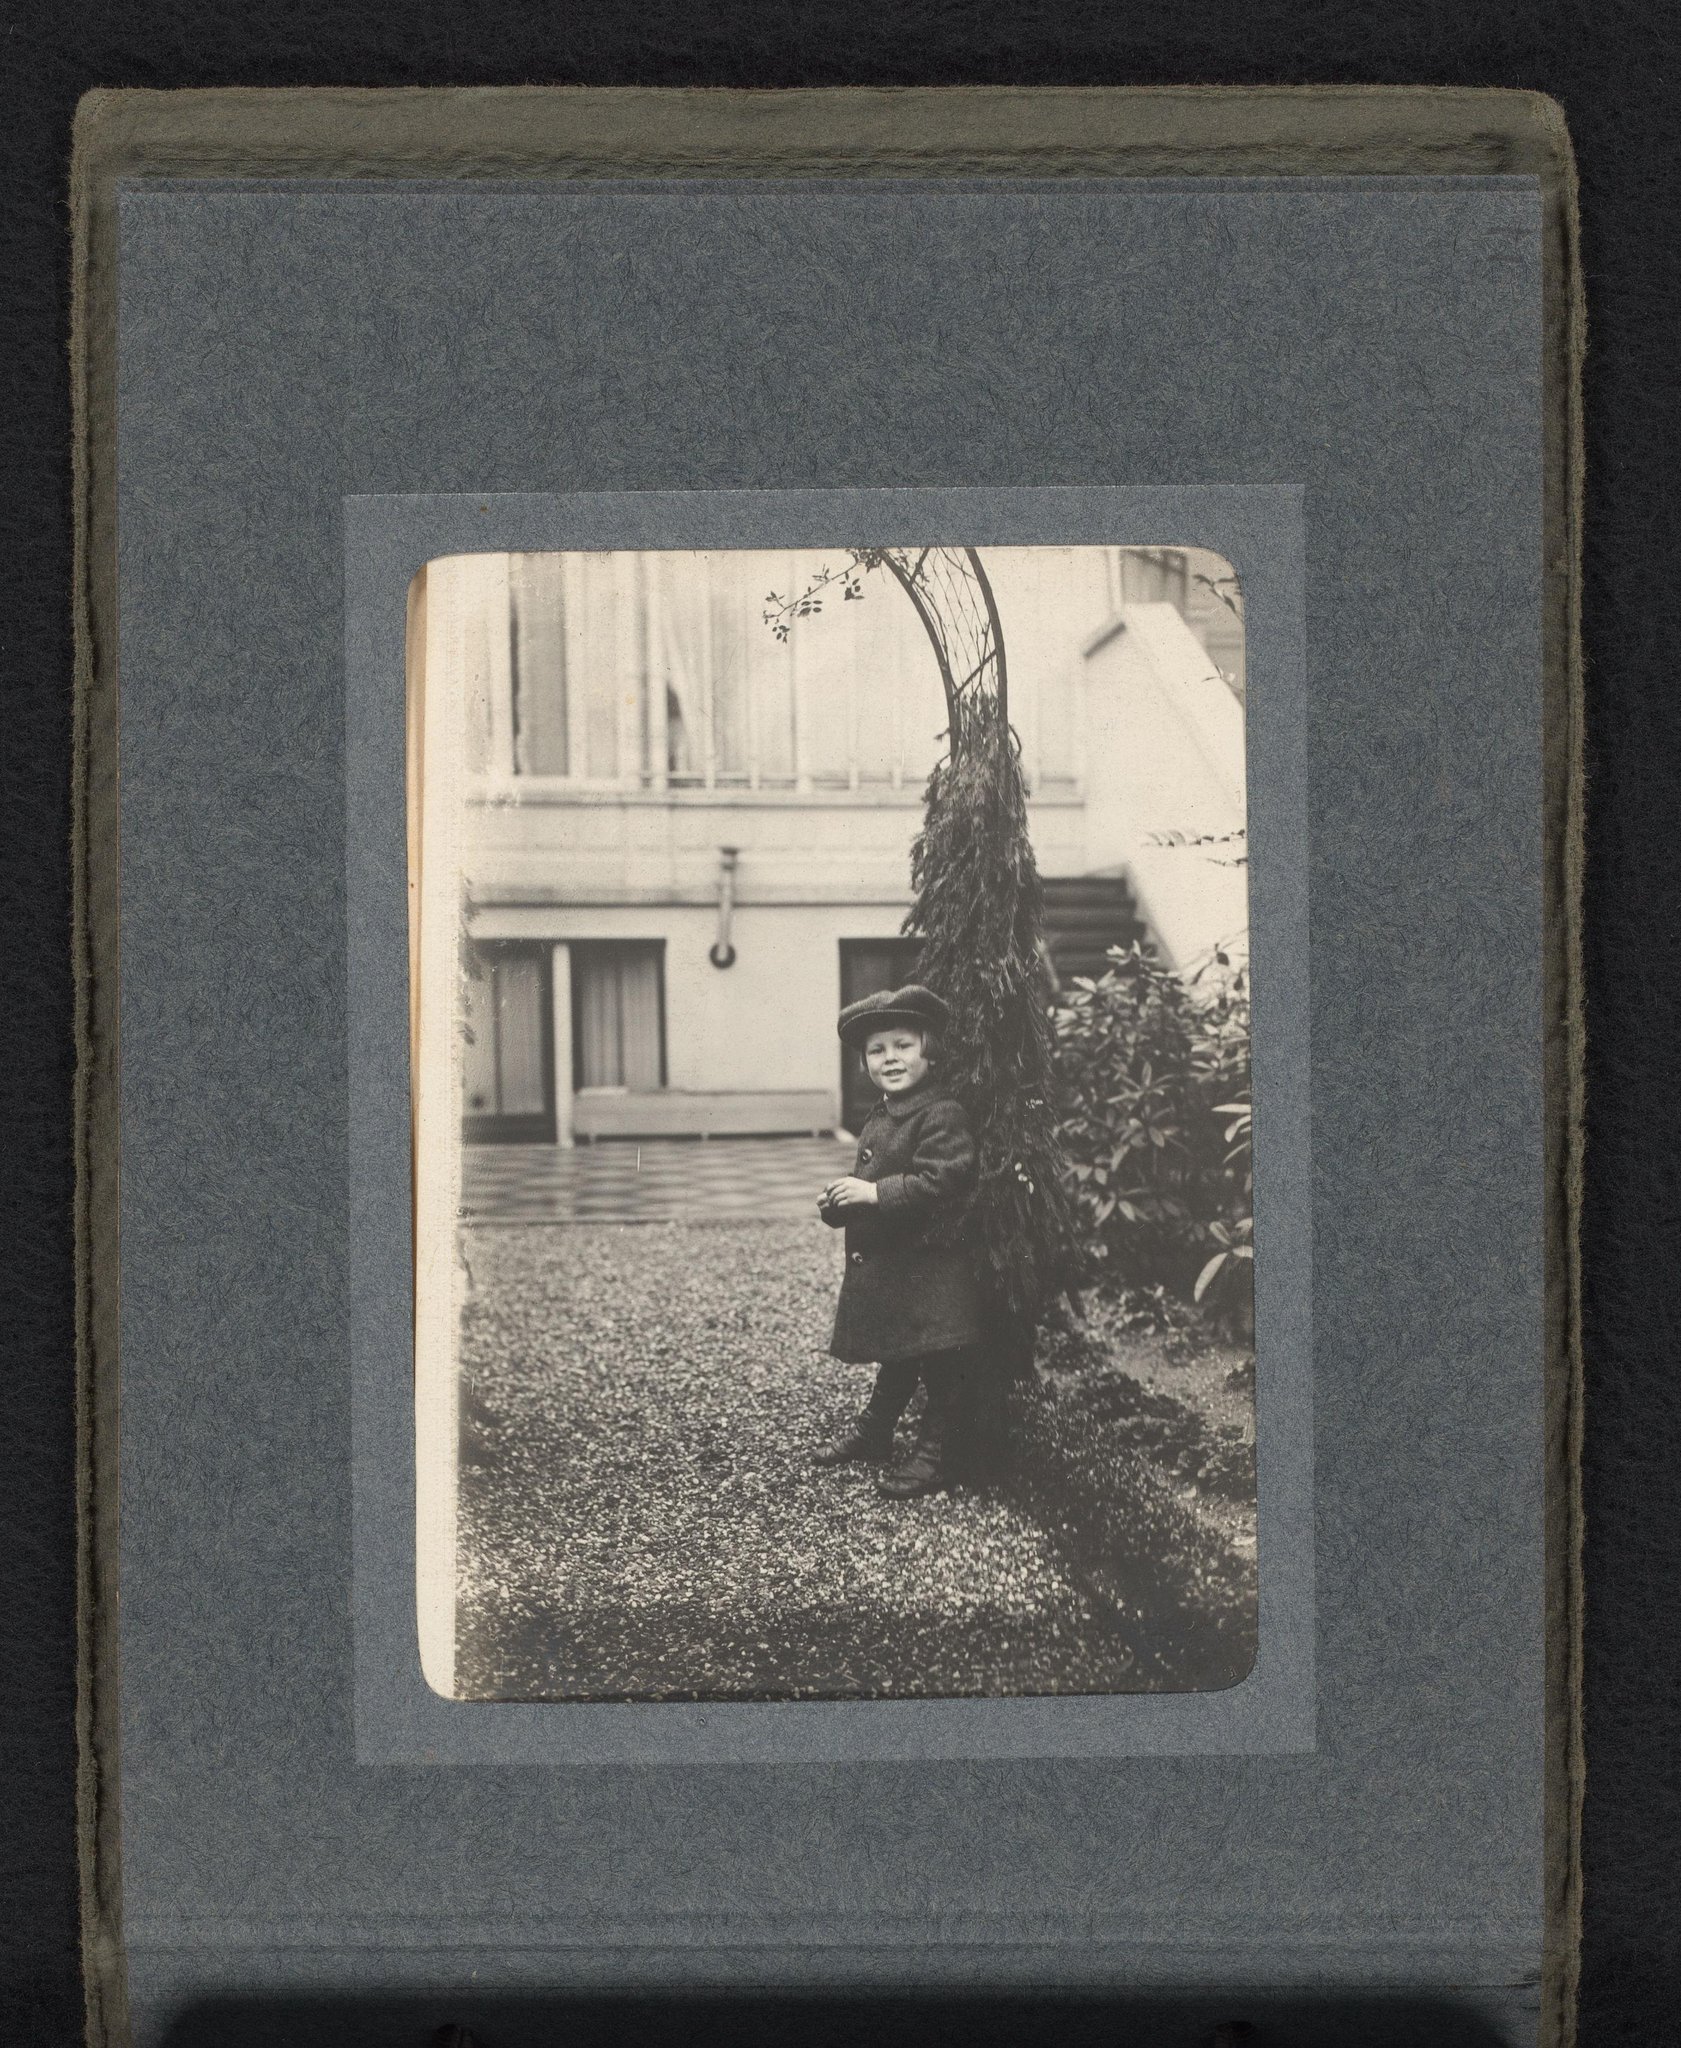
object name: photograph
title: Portret van Cay van den Berg in de tuin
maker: hendrik herman van den berg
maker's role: amateurfotograaf, jurist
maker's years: 1875-1944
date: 1912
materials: paper, cardboard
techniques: gelatin silver print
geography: amsterdam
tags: carel frederik van den berg (cay), toddler, garden, historical persons